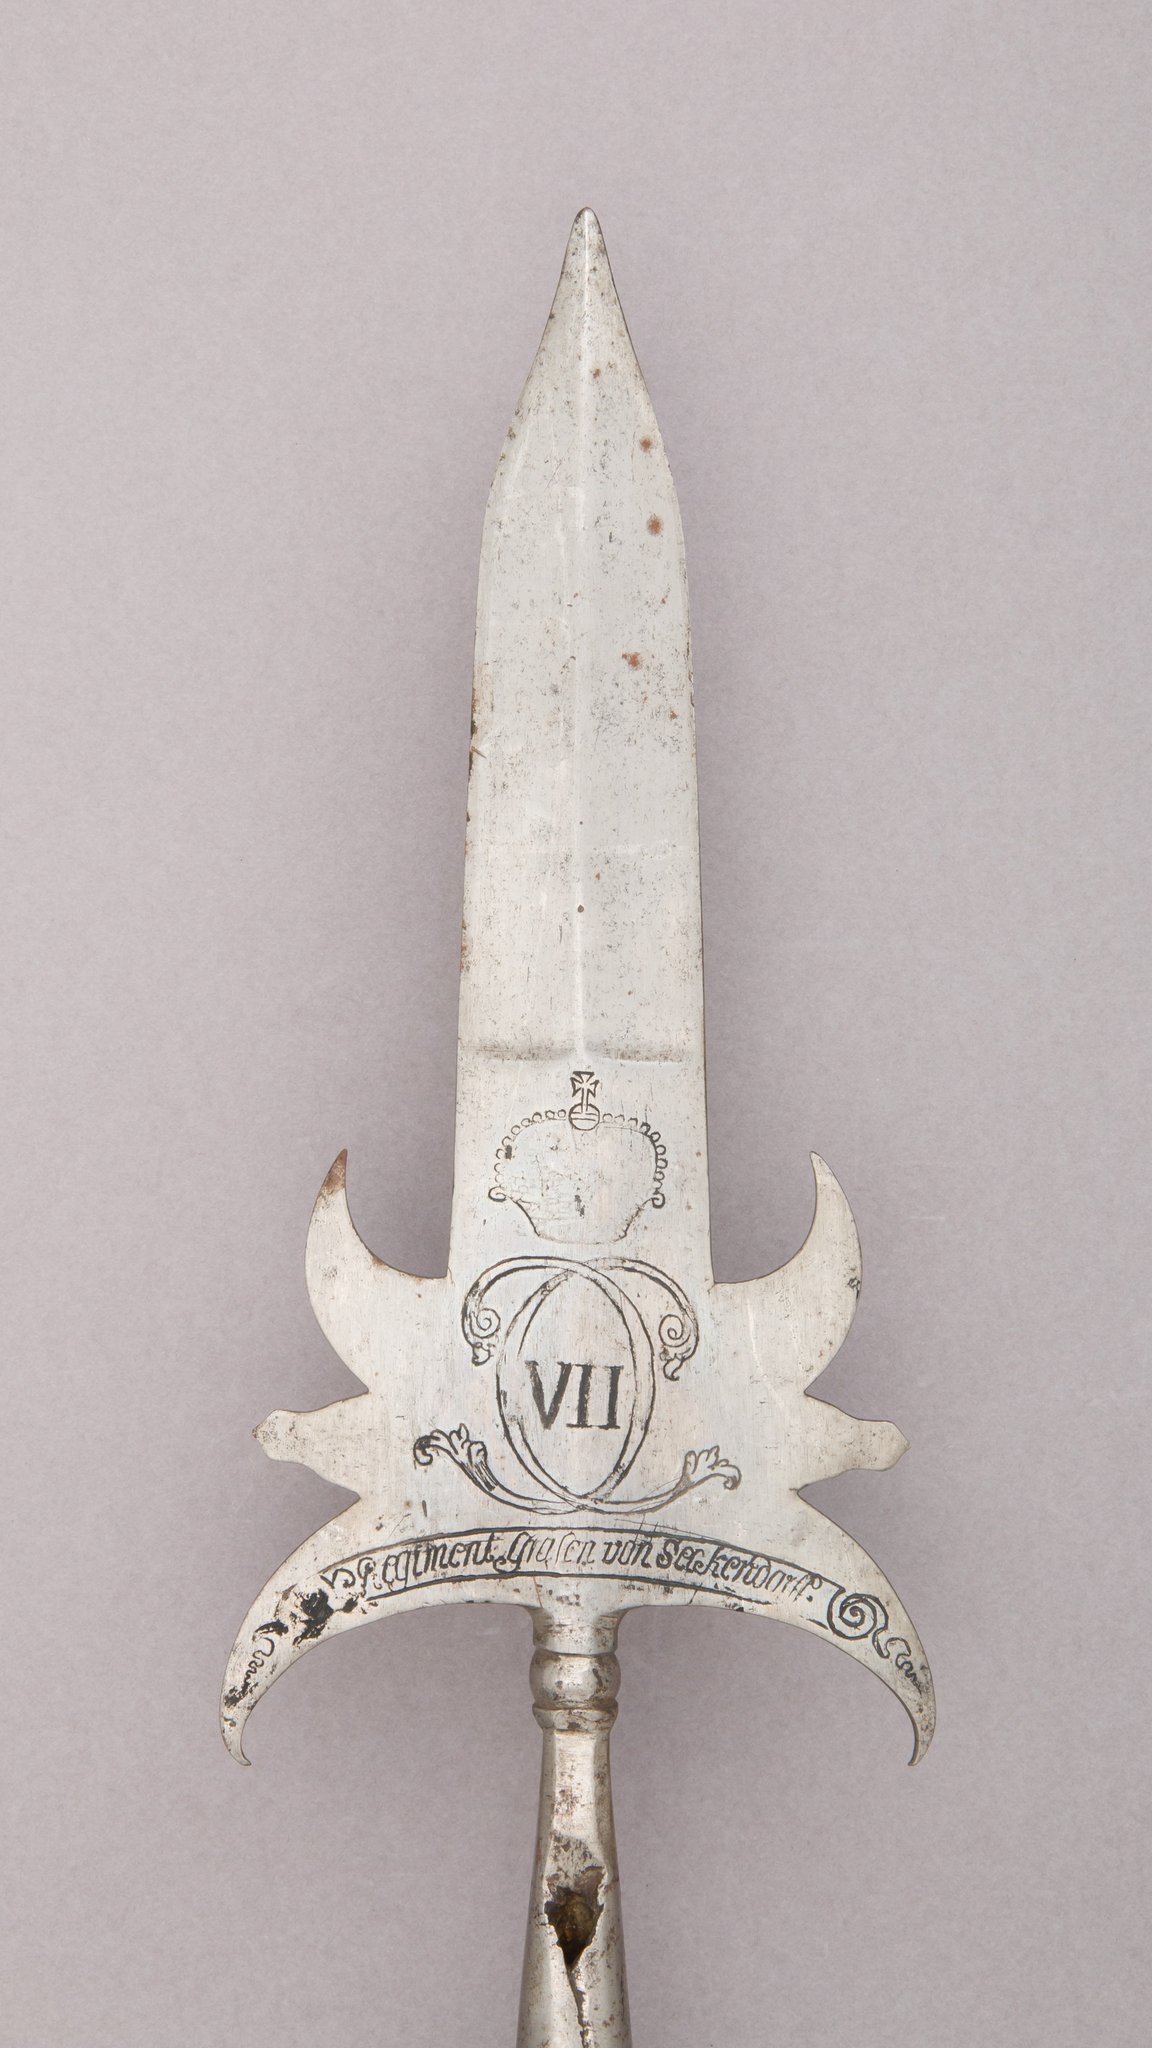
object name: spontoon with fanion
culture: german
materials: steel, textile, wood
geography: germany